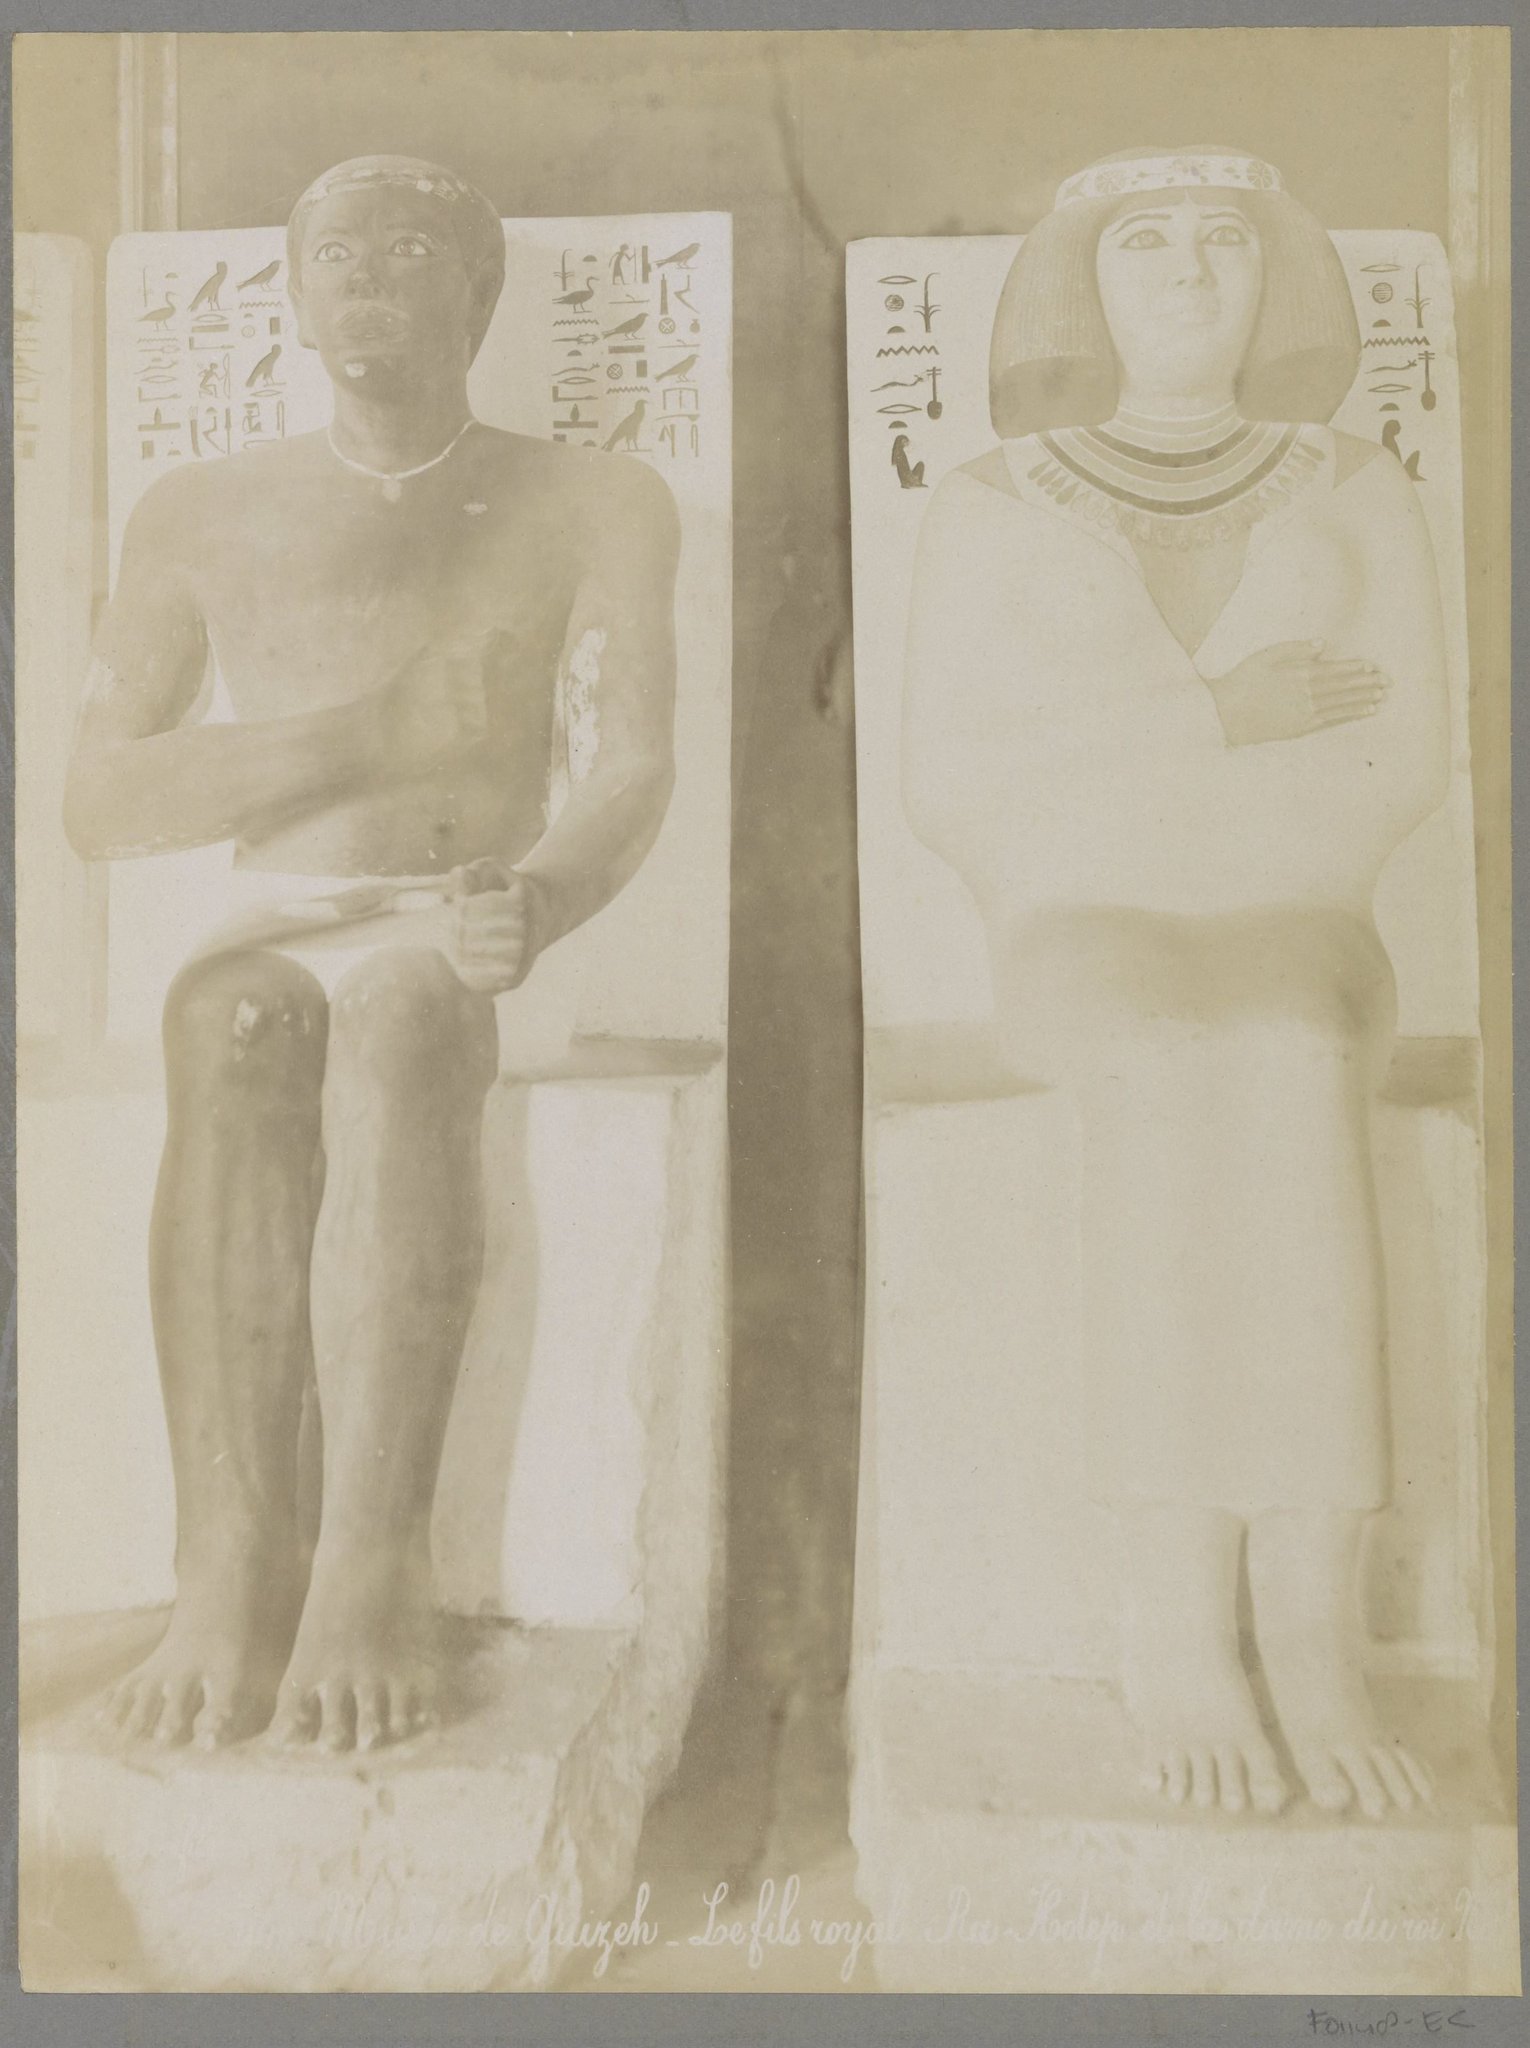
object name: photograph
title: Beelden van een faraozoon en een koningin in het museum van Gizeh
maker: Anonymous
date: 1895-1905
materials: paper, photographic support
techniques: albumen print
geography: gizeh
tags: monument, statue, permanent exhibition, museum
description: Onderdeel van Reisalbum met foto's van bezienswaardigheden in Griekenland en Egypte.